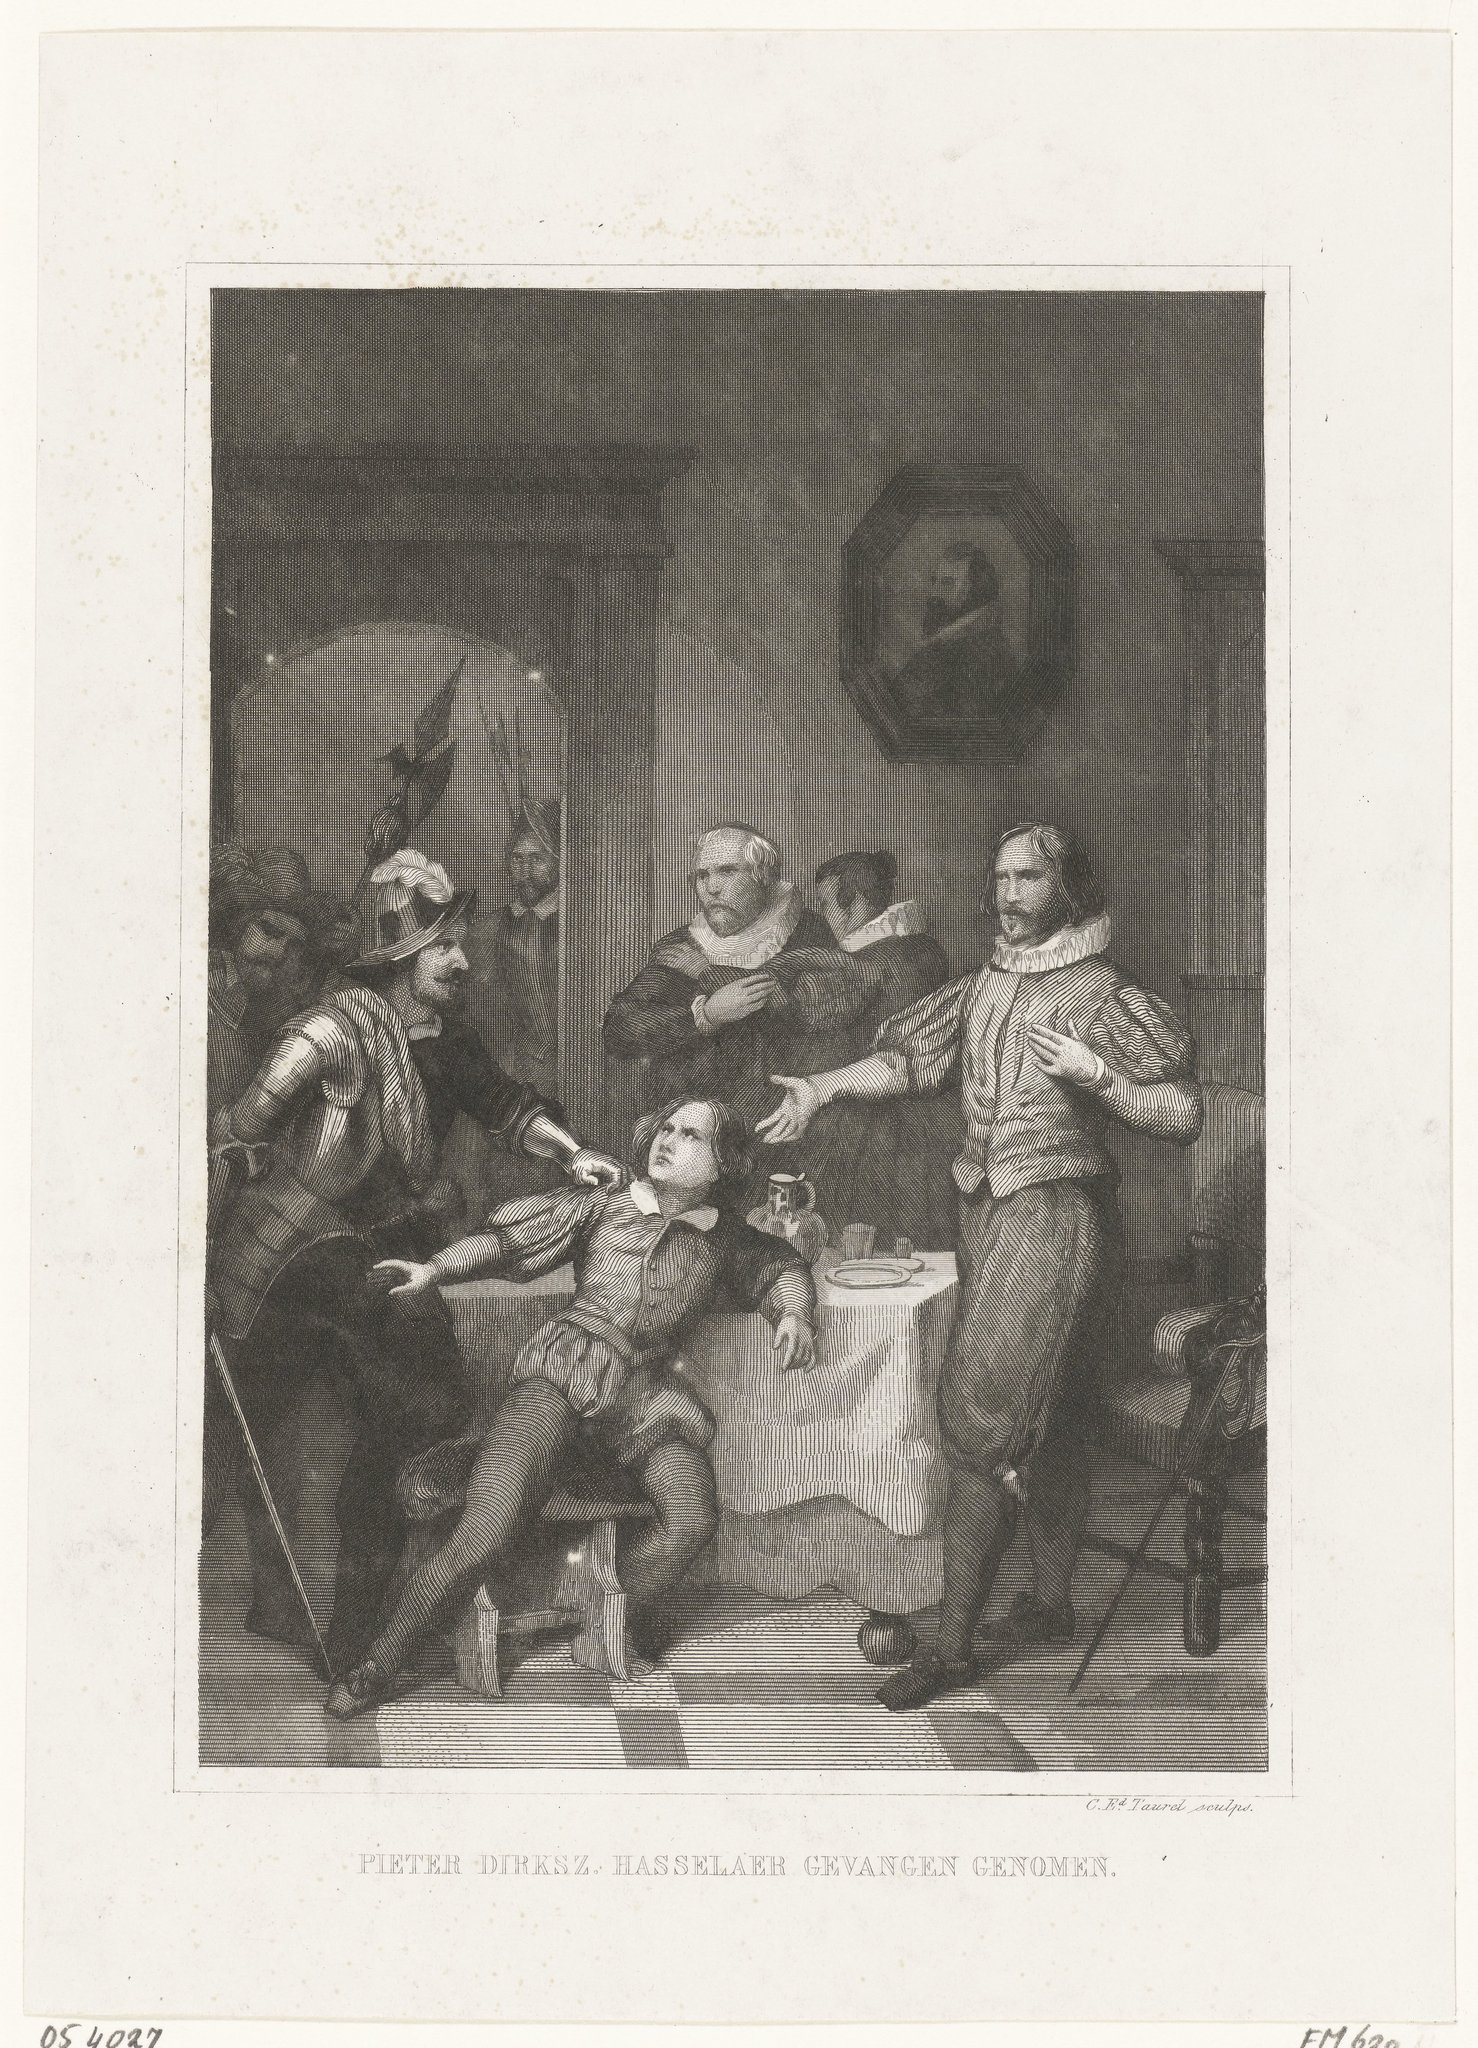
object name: print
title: Gevangenneming van Pieter Hasselaer, 1573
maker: edouard taurel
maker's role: draughtsman, print maker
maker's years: 1824-1892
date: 1849-1851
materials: paper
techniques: engraving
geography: netherlands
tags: haarlem, amsterdam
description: Gebruikt als illustratie in: J.P. Arend, Algemeene geschiedenis des vaderlands, Amsterdam, 5 delen, 1840-1882, dl. 2.5 (1851), p. 274.